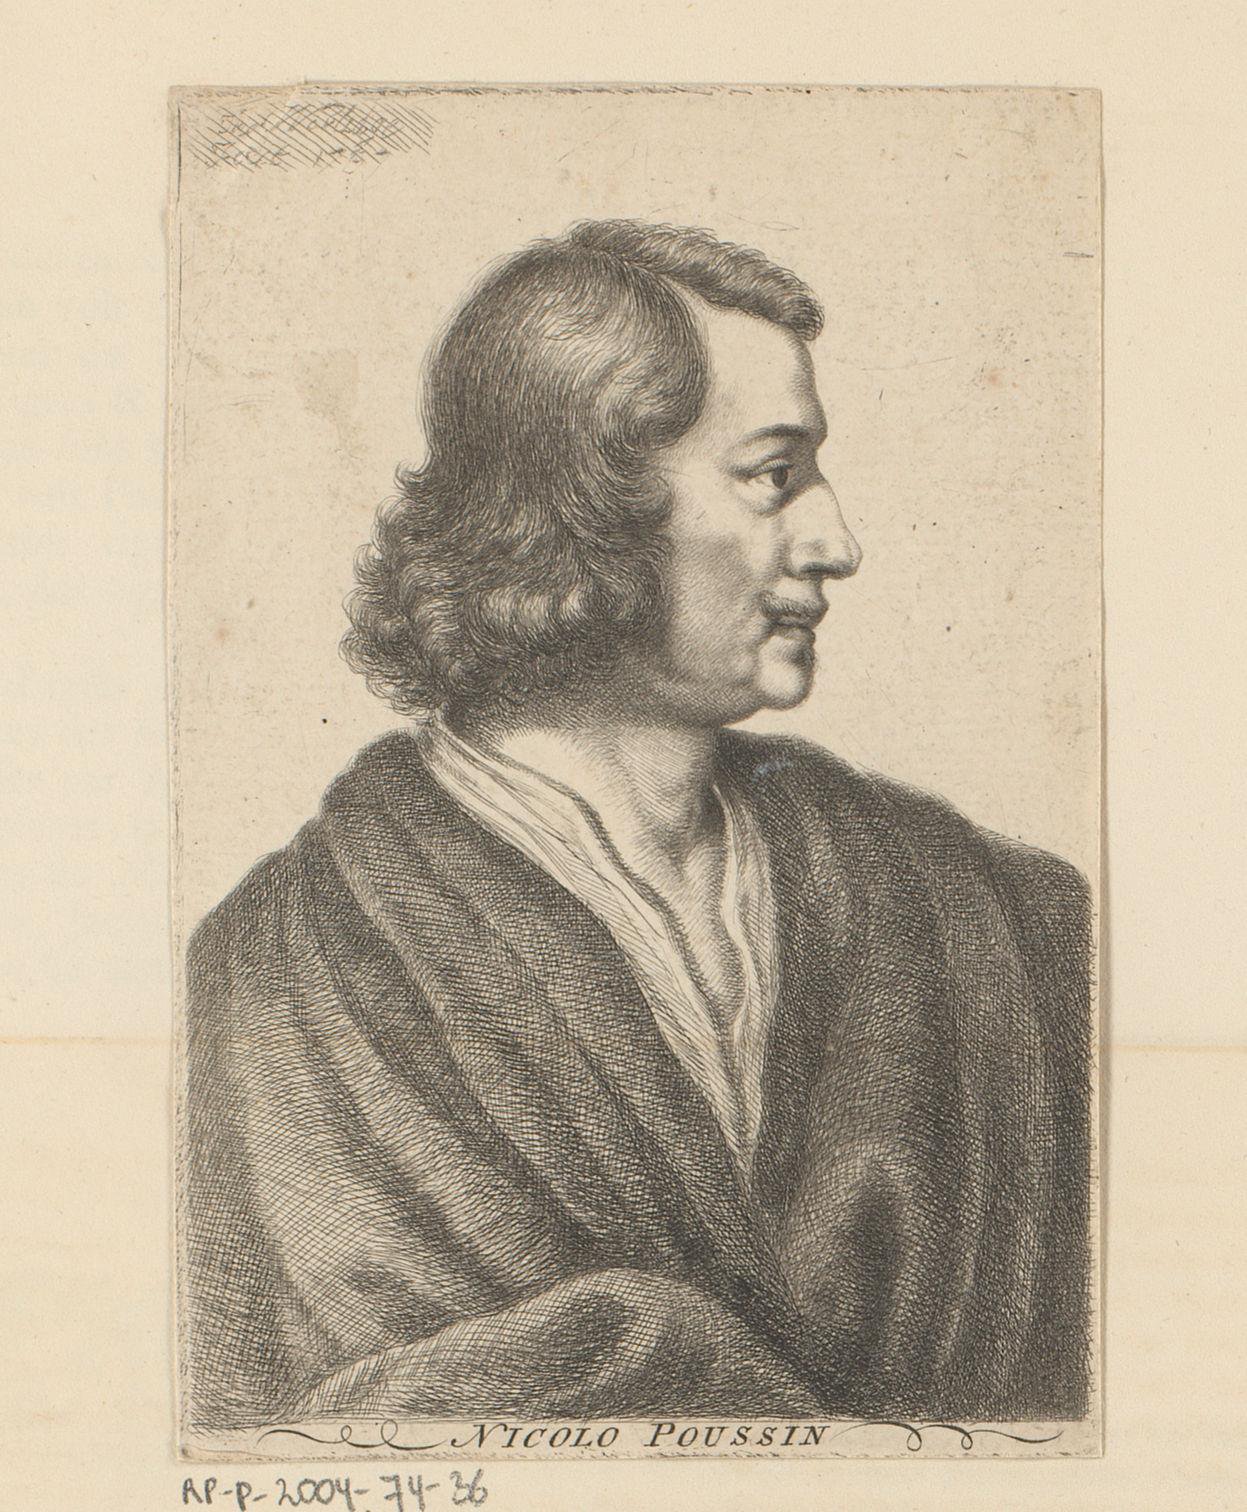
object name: print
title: Portret van Nicolas Poussin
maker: thomas worlidge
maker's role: print maker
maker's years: 1700-1766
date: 1757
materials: paper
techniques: engraving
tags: rome, draughtsman, nicolas poussin, historical persons, portrait, self-portrait of painter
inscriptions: date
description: De samensteller heeft deze prent in het album geplakt als illustratie bij: Pilkington, Matthew en Johann Heinrich Füssli. A dictionary of painters, from the revival of the art to the present period. 4 dln. Londen: John Crowder, 1805, dl. 3, p. 415.